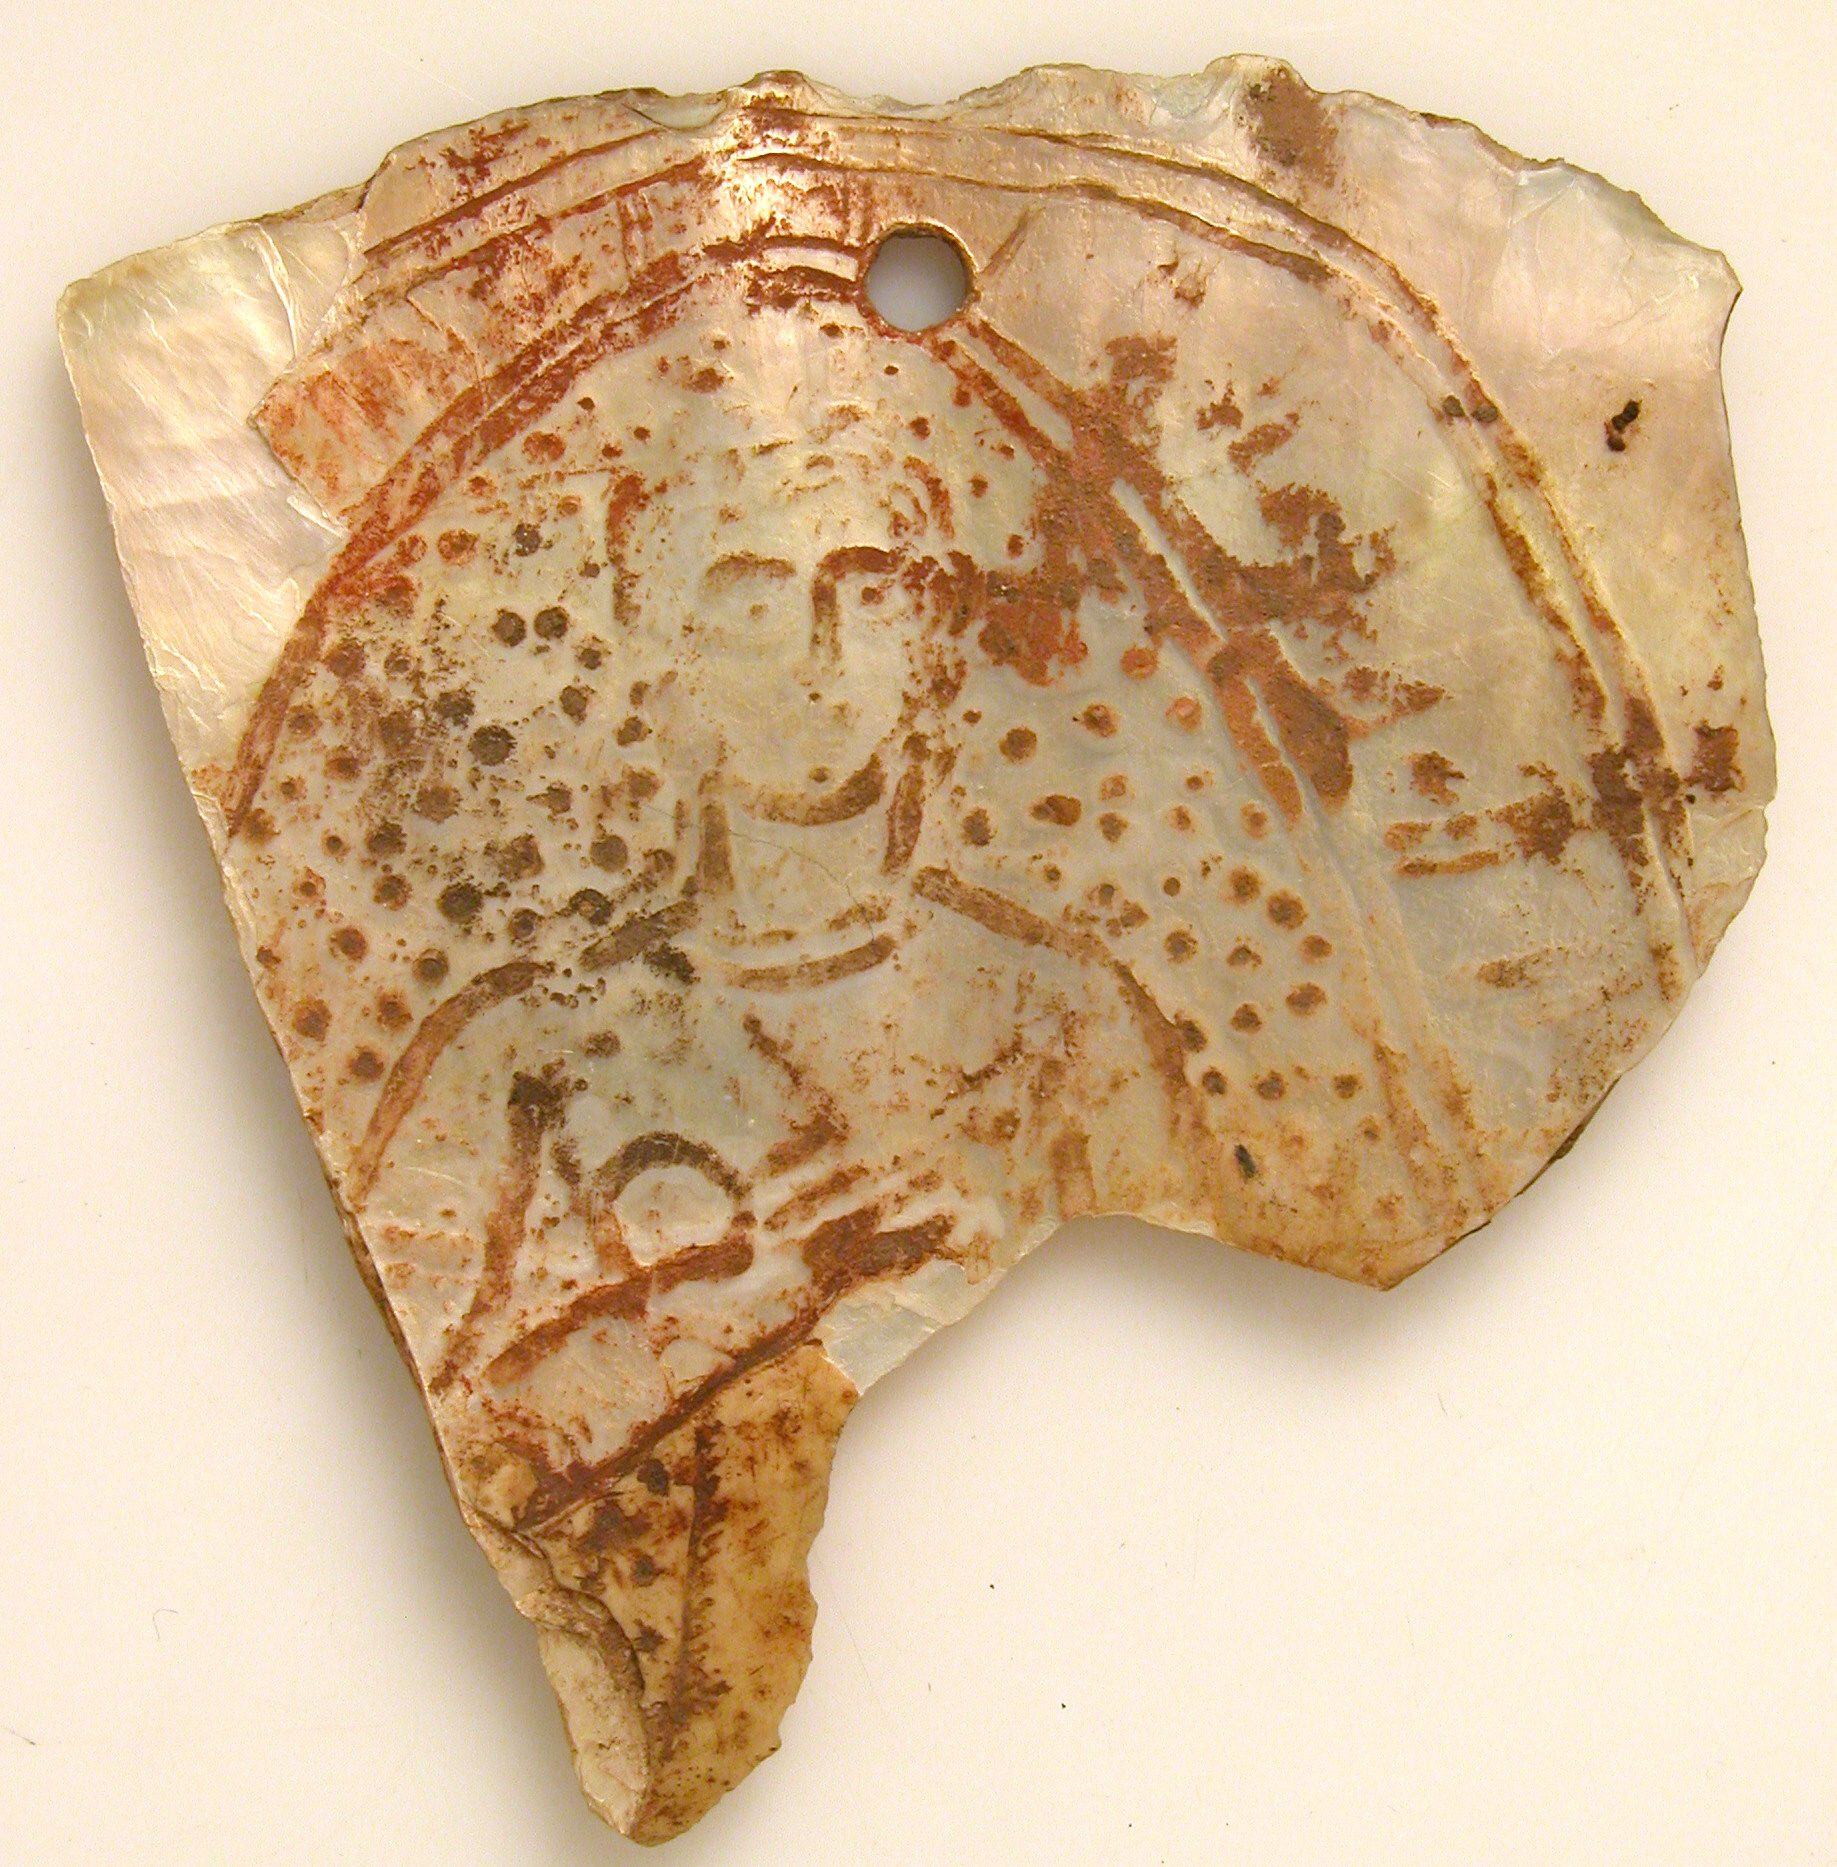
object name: plaque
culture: coptic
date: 701-900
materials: mother of pearl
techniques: polychromy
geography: egypt